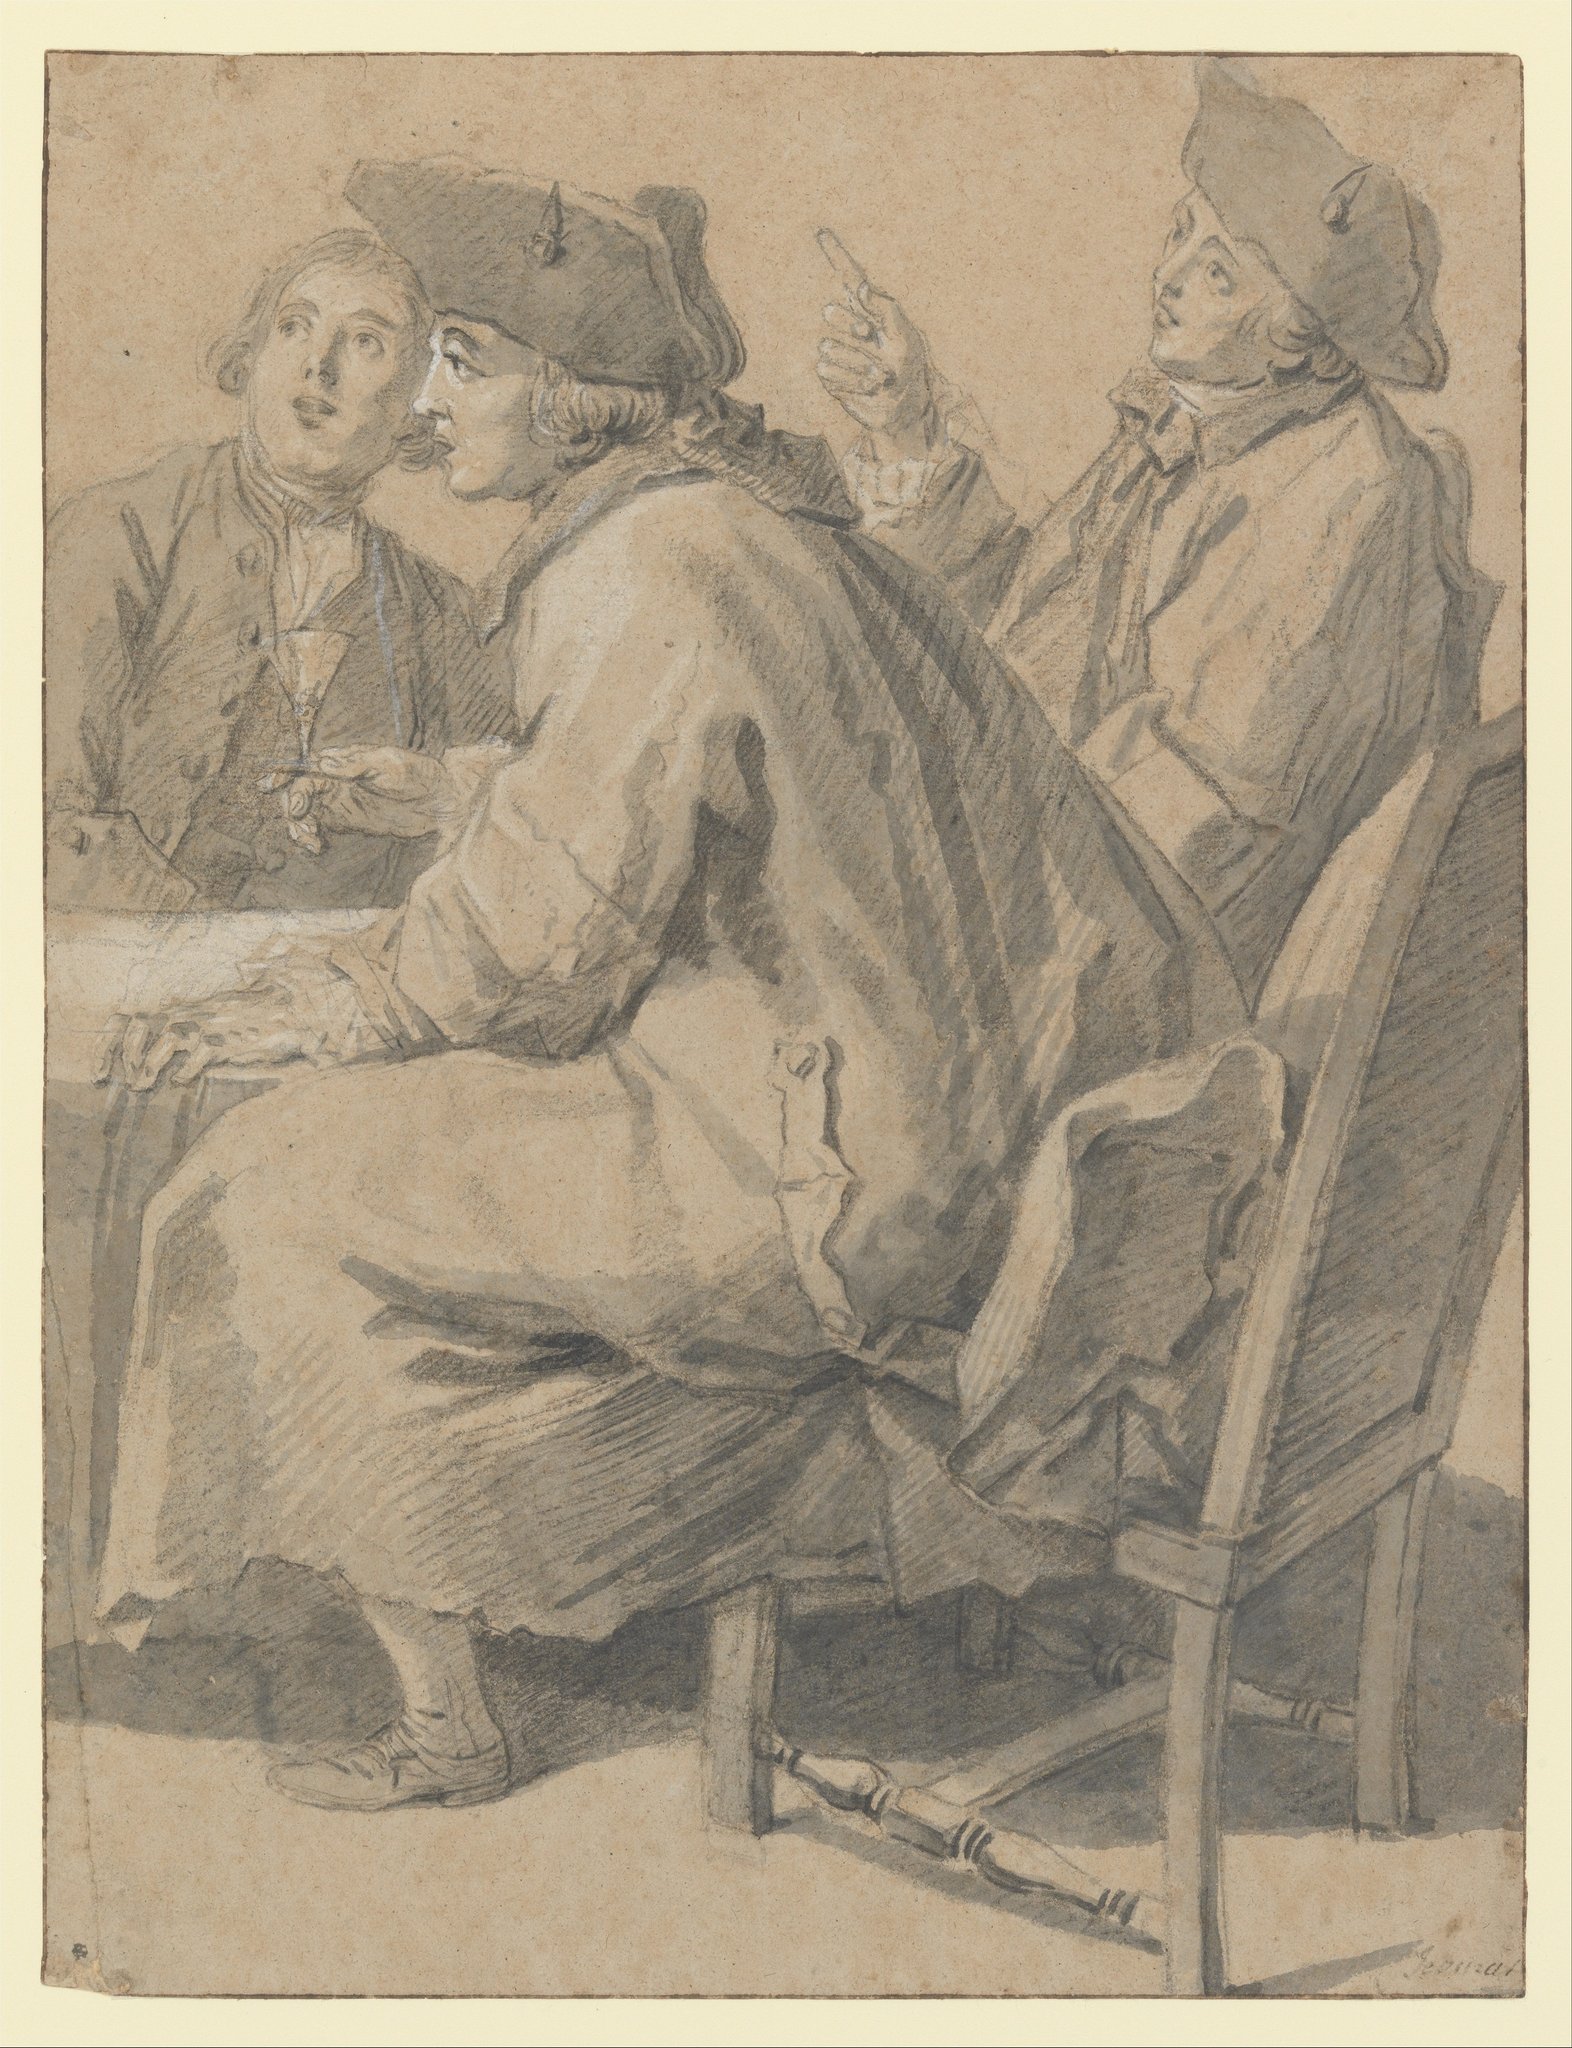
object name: drawing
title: Three Men at a Table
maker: etienne jeaurat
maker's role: artist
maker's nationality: french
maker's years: 1699-1789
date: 1763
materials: chalk, gouache, ink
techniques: brush, heightening, pen, wash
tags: men